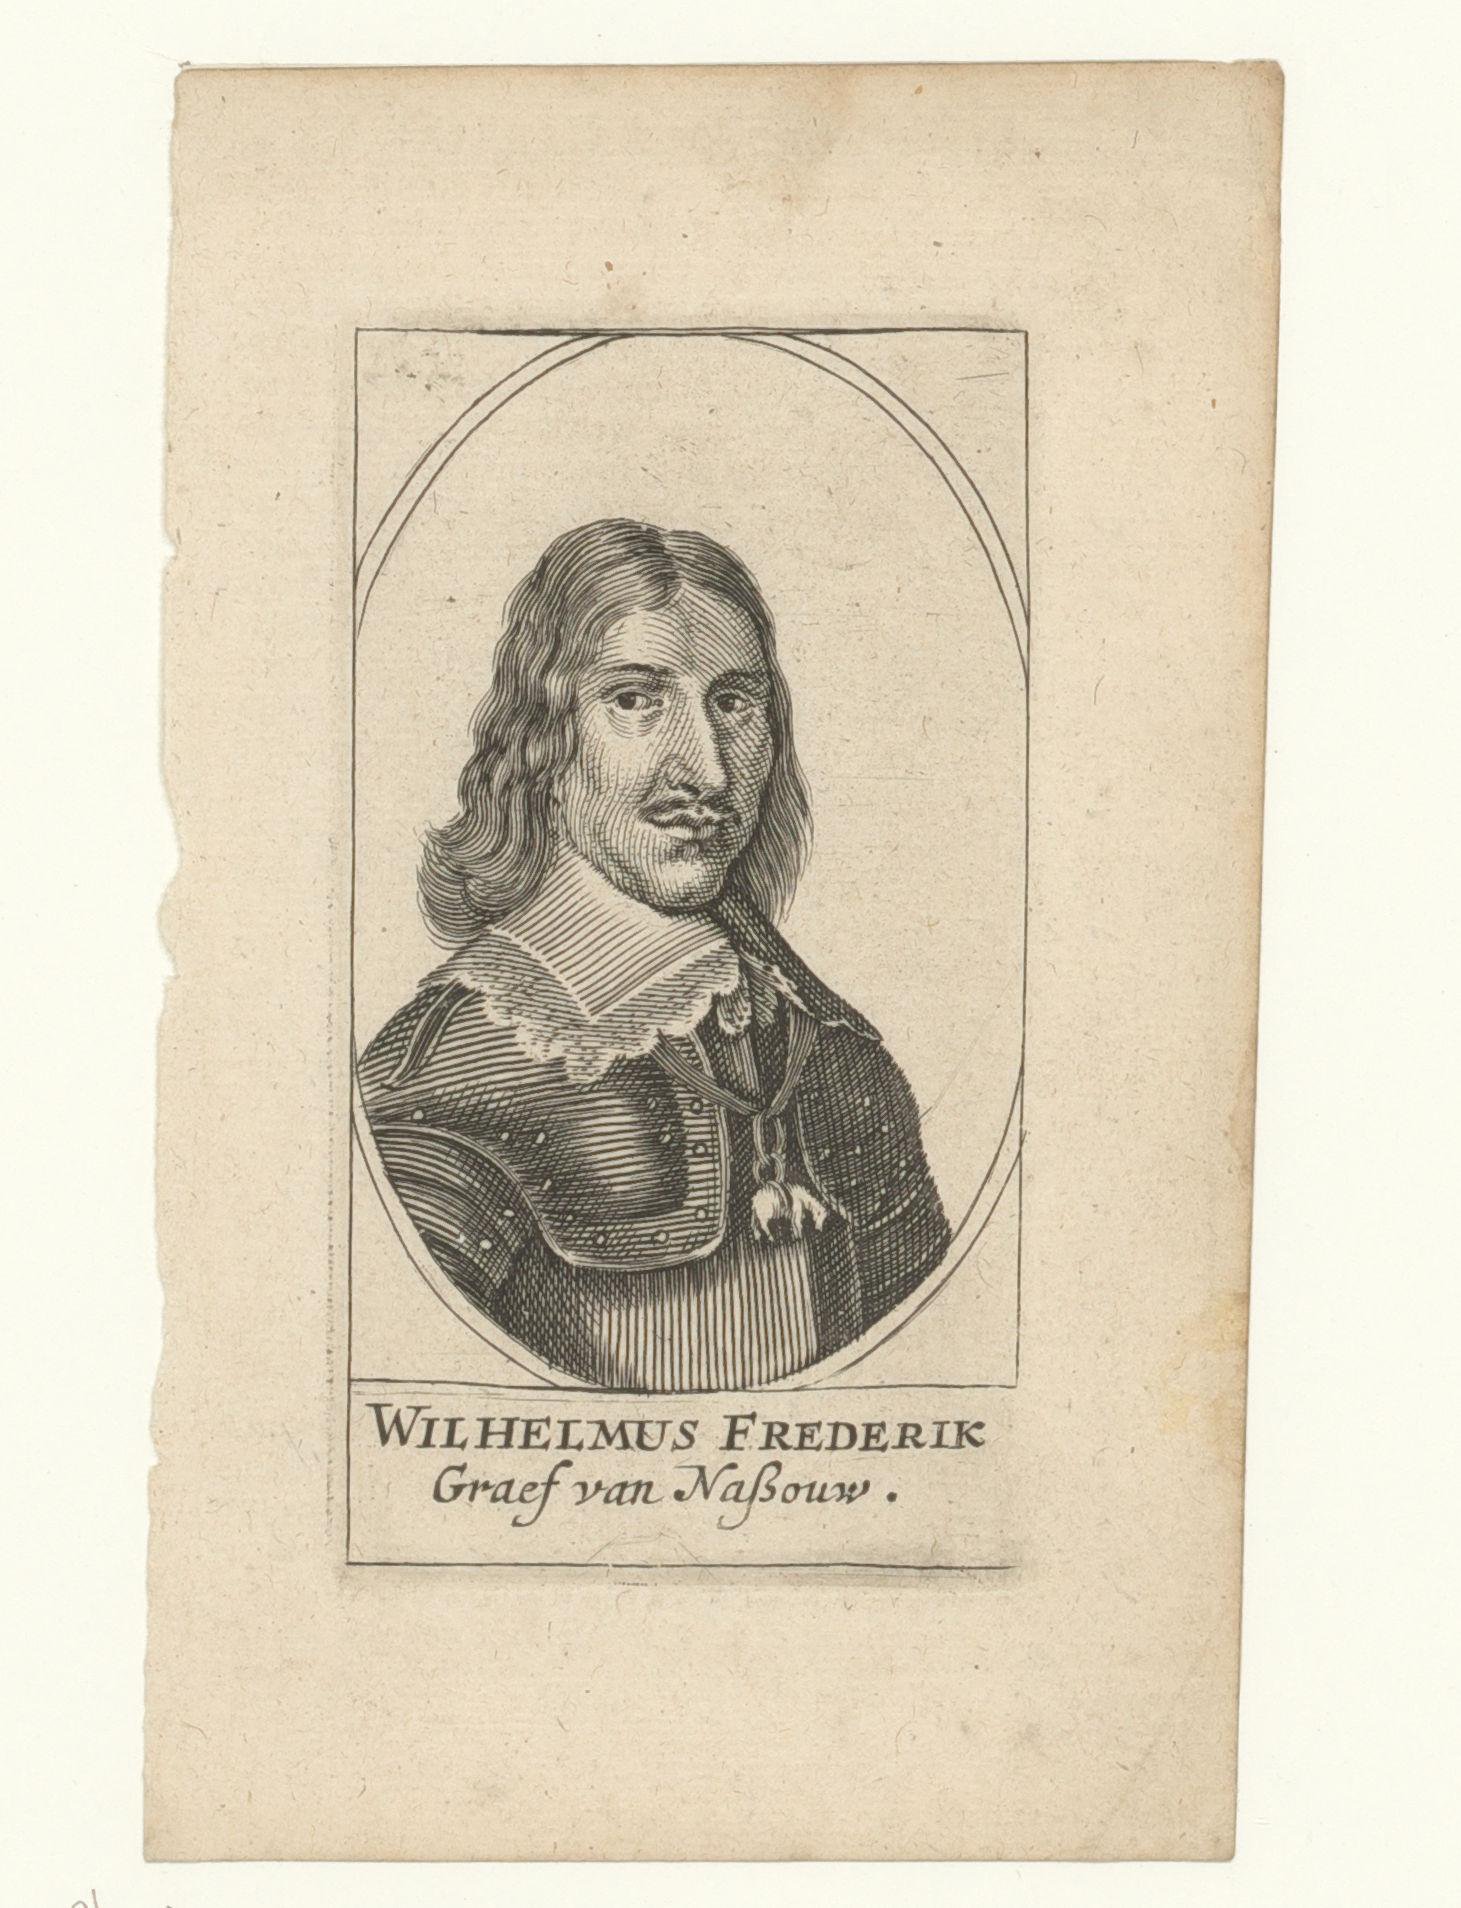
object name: print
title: Wilhelmus Frederik Graef van Naẞouw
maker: Anonymous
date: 1664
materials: paper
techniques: engraving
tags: arnhem, historical persons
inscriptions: collector's mark: Lugt 1641, stamp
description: Prent waarschijnlijk uit: Montanus, Arnoldus. 't Leven en bedryf der Prinsen van Oranie: Wilhem de eerste, Maurits, Frederik Henrik, Wilhem de tweede, Wilhem de derde. Amsterdam: Arent van den Heuvel en Samuel Imbrecht, 1664. Eerdere staat gebruikt in: Montanus, Arnoldus. 't Vermeerderde leven en bedryf van Frederik Hendrik, prinse van Oranjen. Amsterdam: Cornelis Jansz. 1653. En andere publicaties.